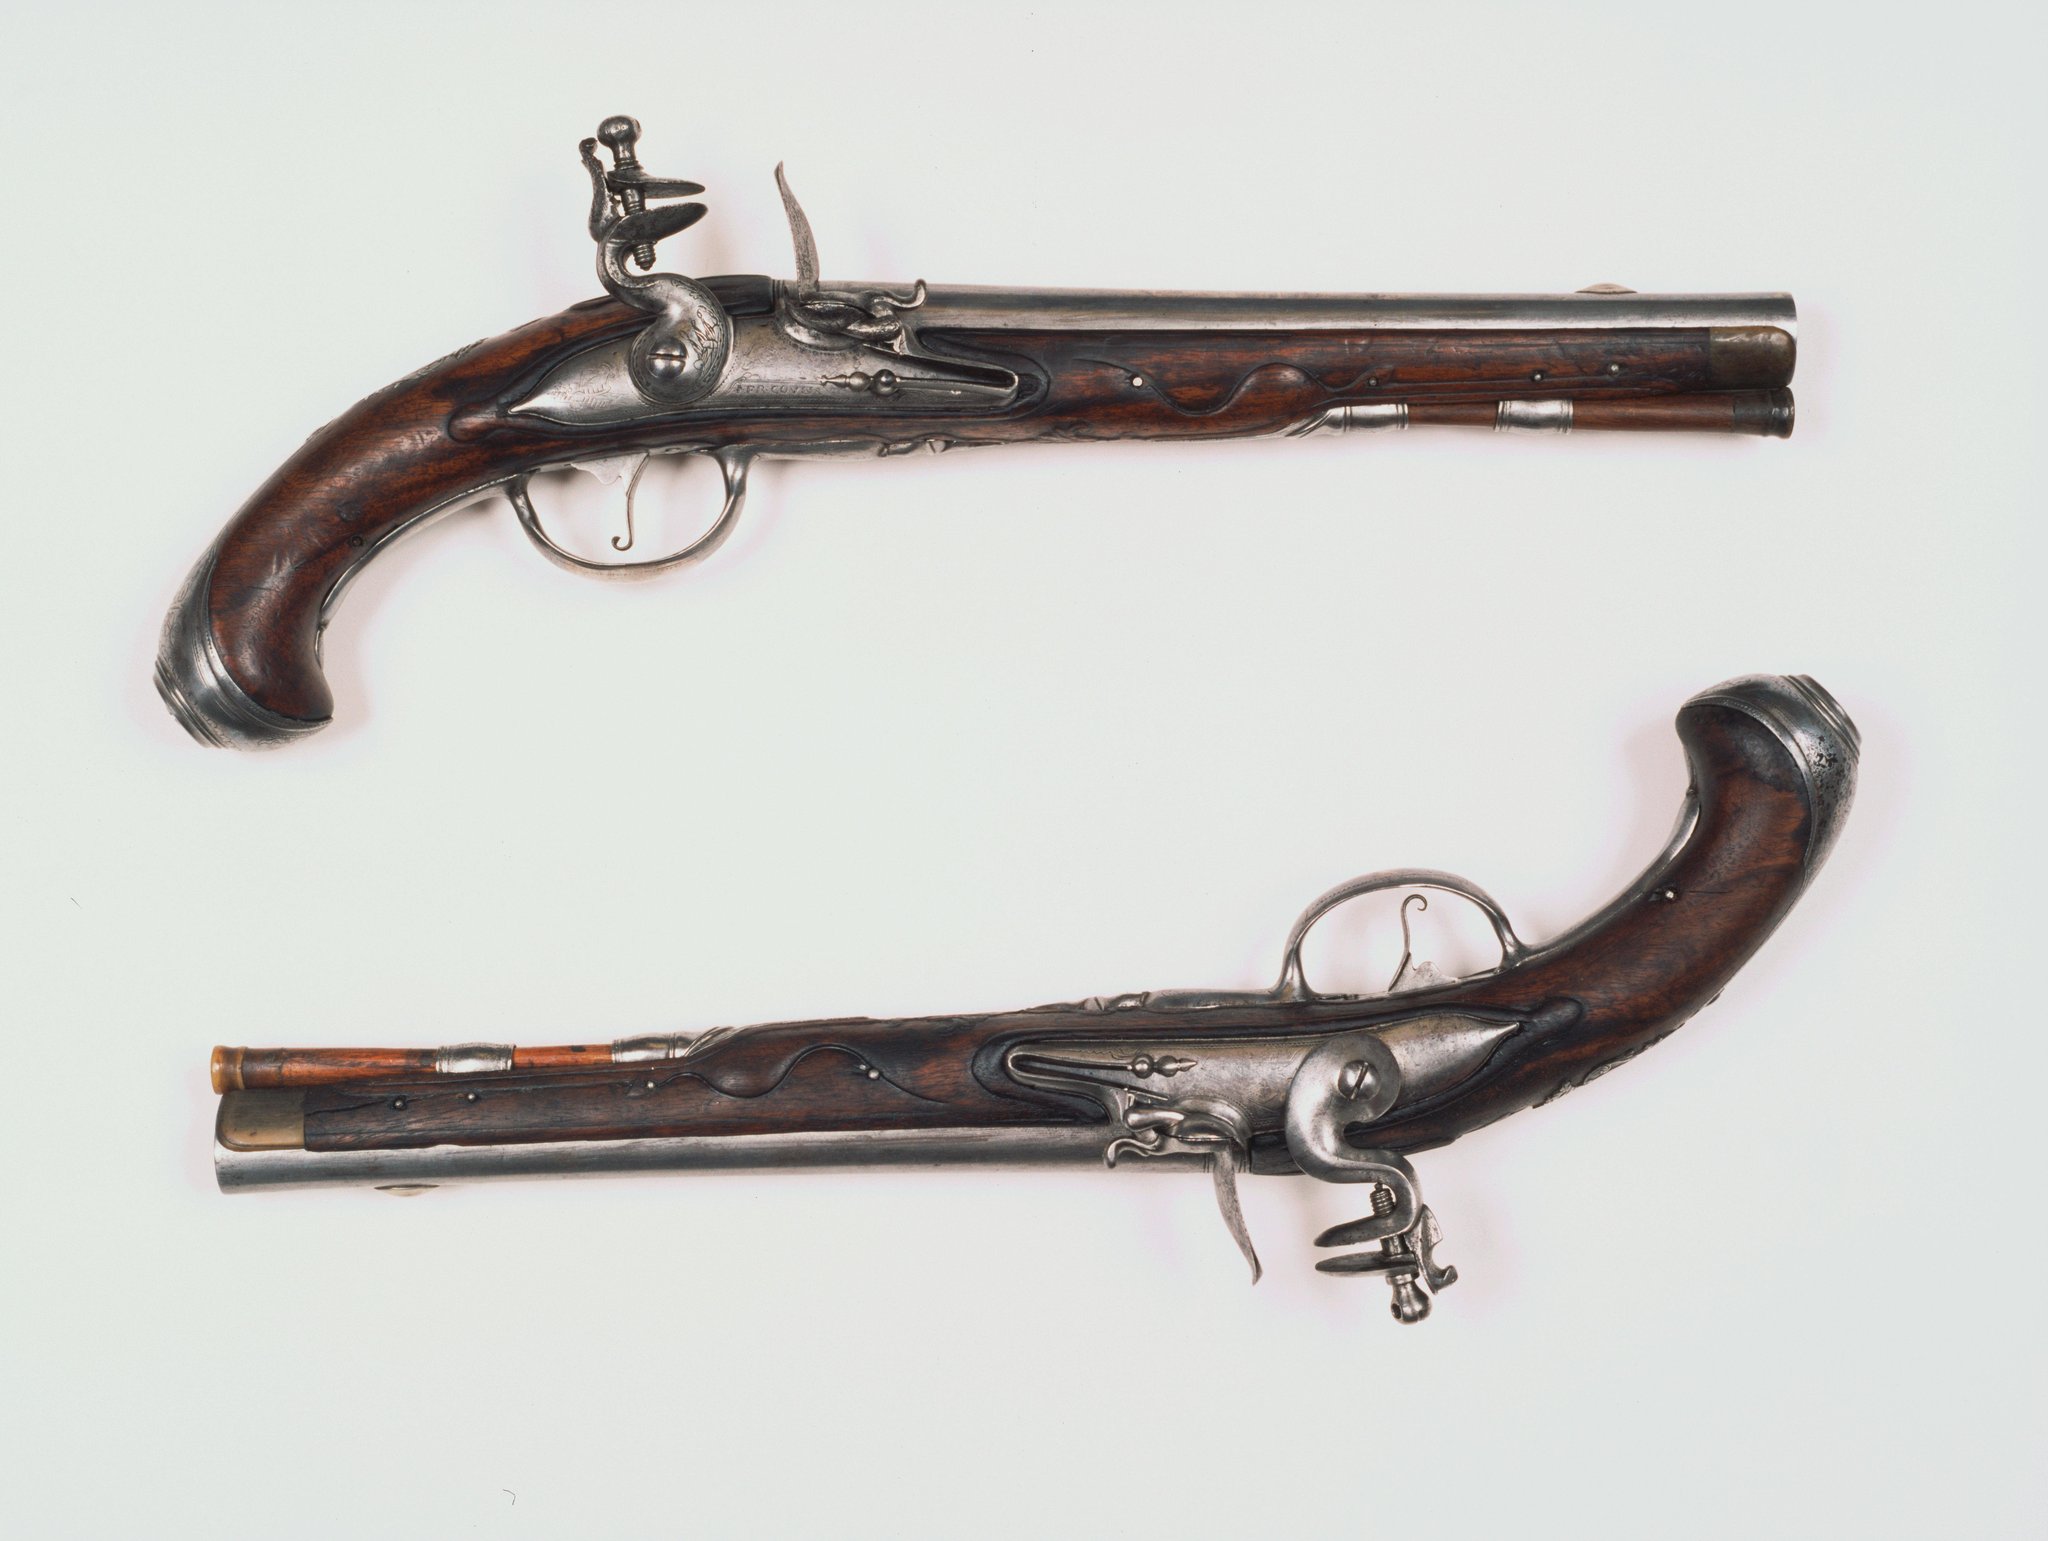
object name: flintlock pistol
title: Vuursteenpistool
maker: Anonymous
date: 1699-1899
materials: horn, iron, wood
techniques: metalworking, embroidery, engraving, relief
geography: western europe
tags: netherlands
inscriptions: mark: ‘IFR. COVNA’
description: Vuursteenpistool met ijzeren ronde loop met aan het uiteinde een ijzeren vizierkorrel. Houten lade met ingekerfde bladmotieven met aan uiteinde ingelegd hoorn. IJzeren gegraveerde ronde slotplaat en haan met aan de onderzijde de merknaam "IFR. COVNA", gegraveerde haan en roestige vuurstaal, andere zijde ijzeren beslag met bladmotieven. De kolf is van hout met een ijzeren kolfplaat waarop een graveerde wapentrofee van vaandels, trommen en een schild met daarboven een figuur. Op de kolfhals een ijzeren bloemmotief met daarboven een in hout uitgesneden blad. IJzeren trekkerbeugel met ijzeren trekker. Onder de houten lade een houten laadstok waarvan de kop van hoorn is.